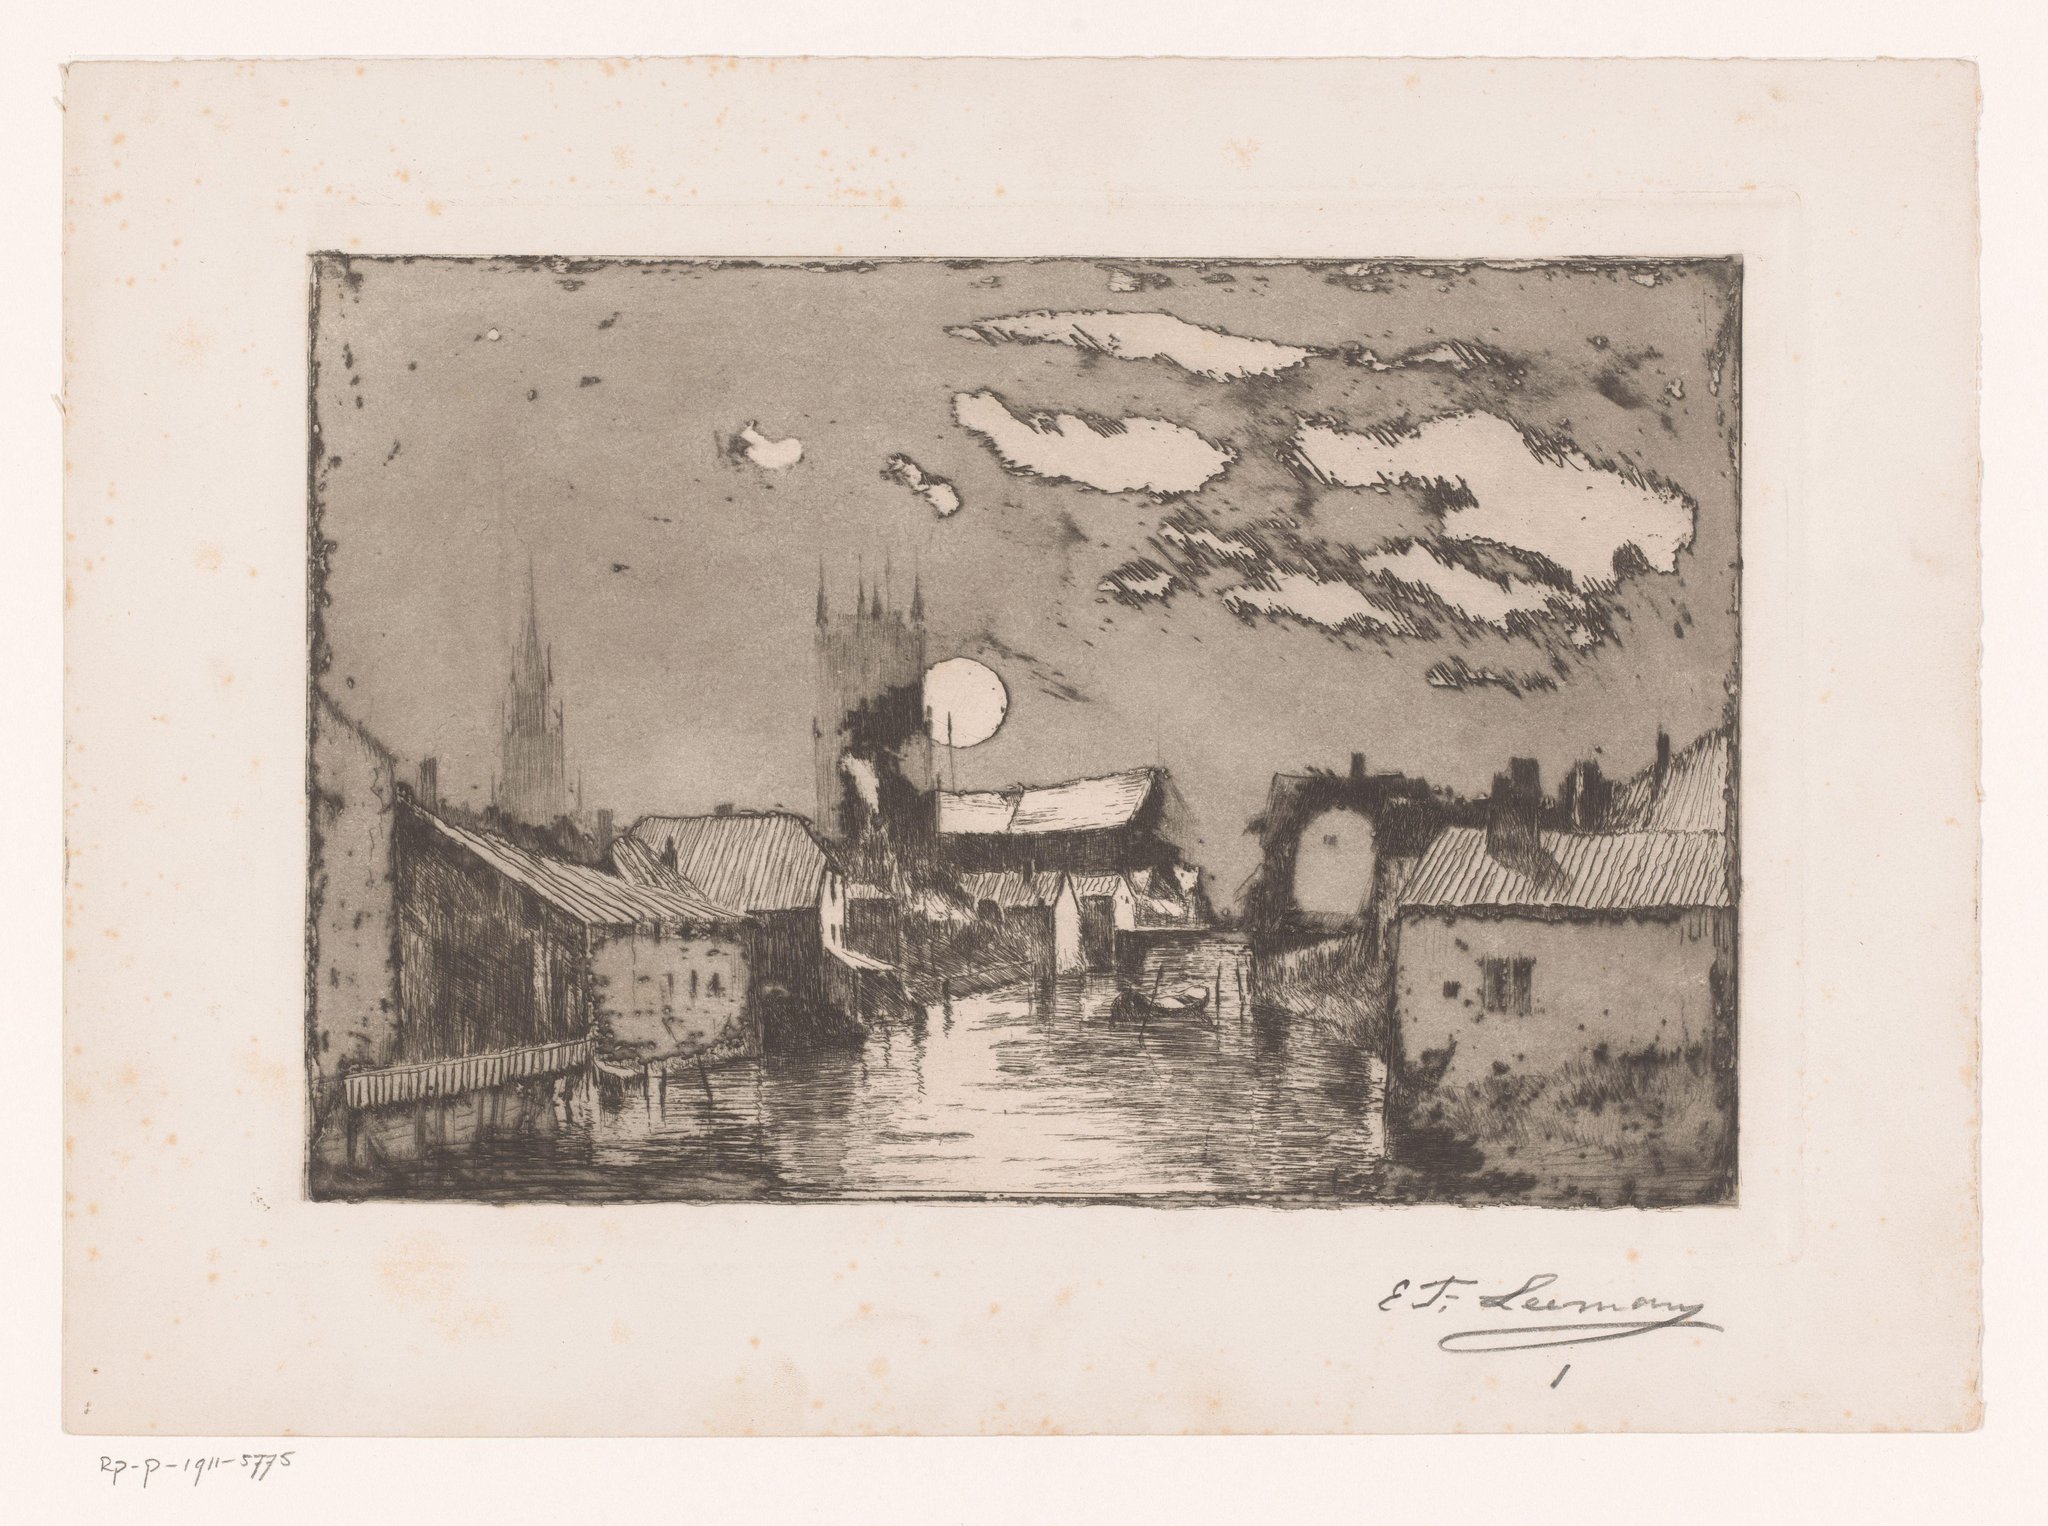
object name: print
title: Riviergezicht in Gent bij maanlicht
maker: egide françois leemans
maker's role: print maker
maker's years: 1839-1883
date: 1849-1883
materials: paper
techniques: aquatint, etching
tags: church (exterior), canals, waters (in city), ghent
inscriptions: collector's mark: Lugt 2228